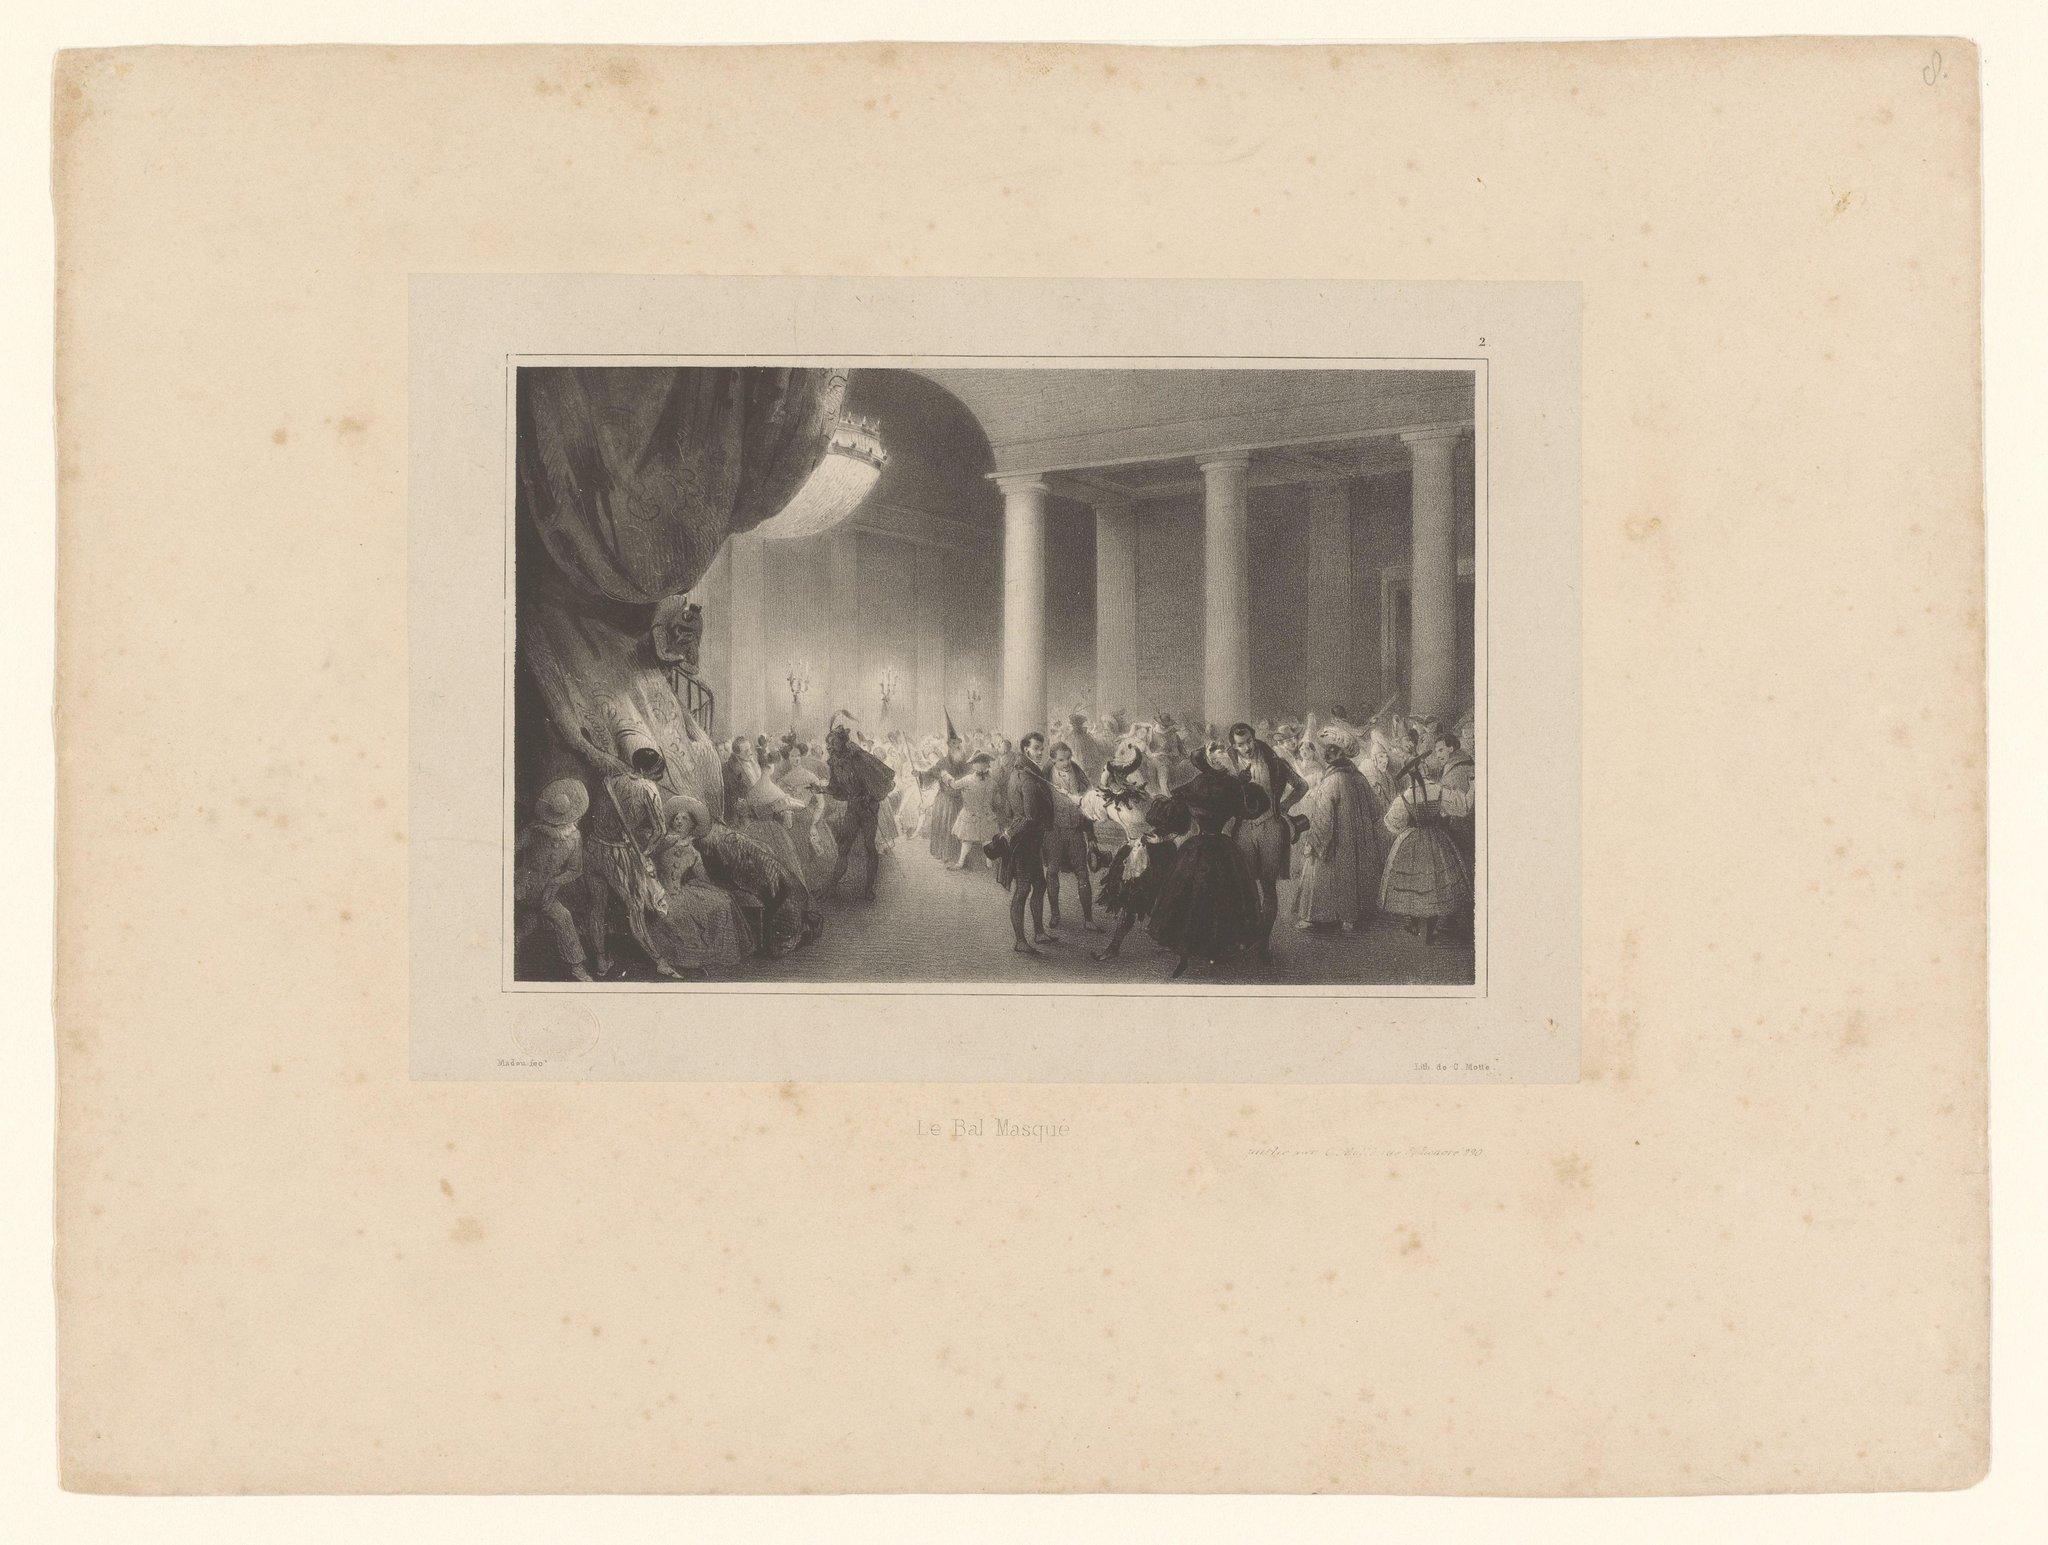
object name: print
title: Douze dessins lithographiques pour 1833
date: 1833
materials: paper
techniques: lithograph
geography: paris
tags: masquerade, masked ball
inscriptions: collector's mark: Lugt 2228, check stamp: Lugt 1828b